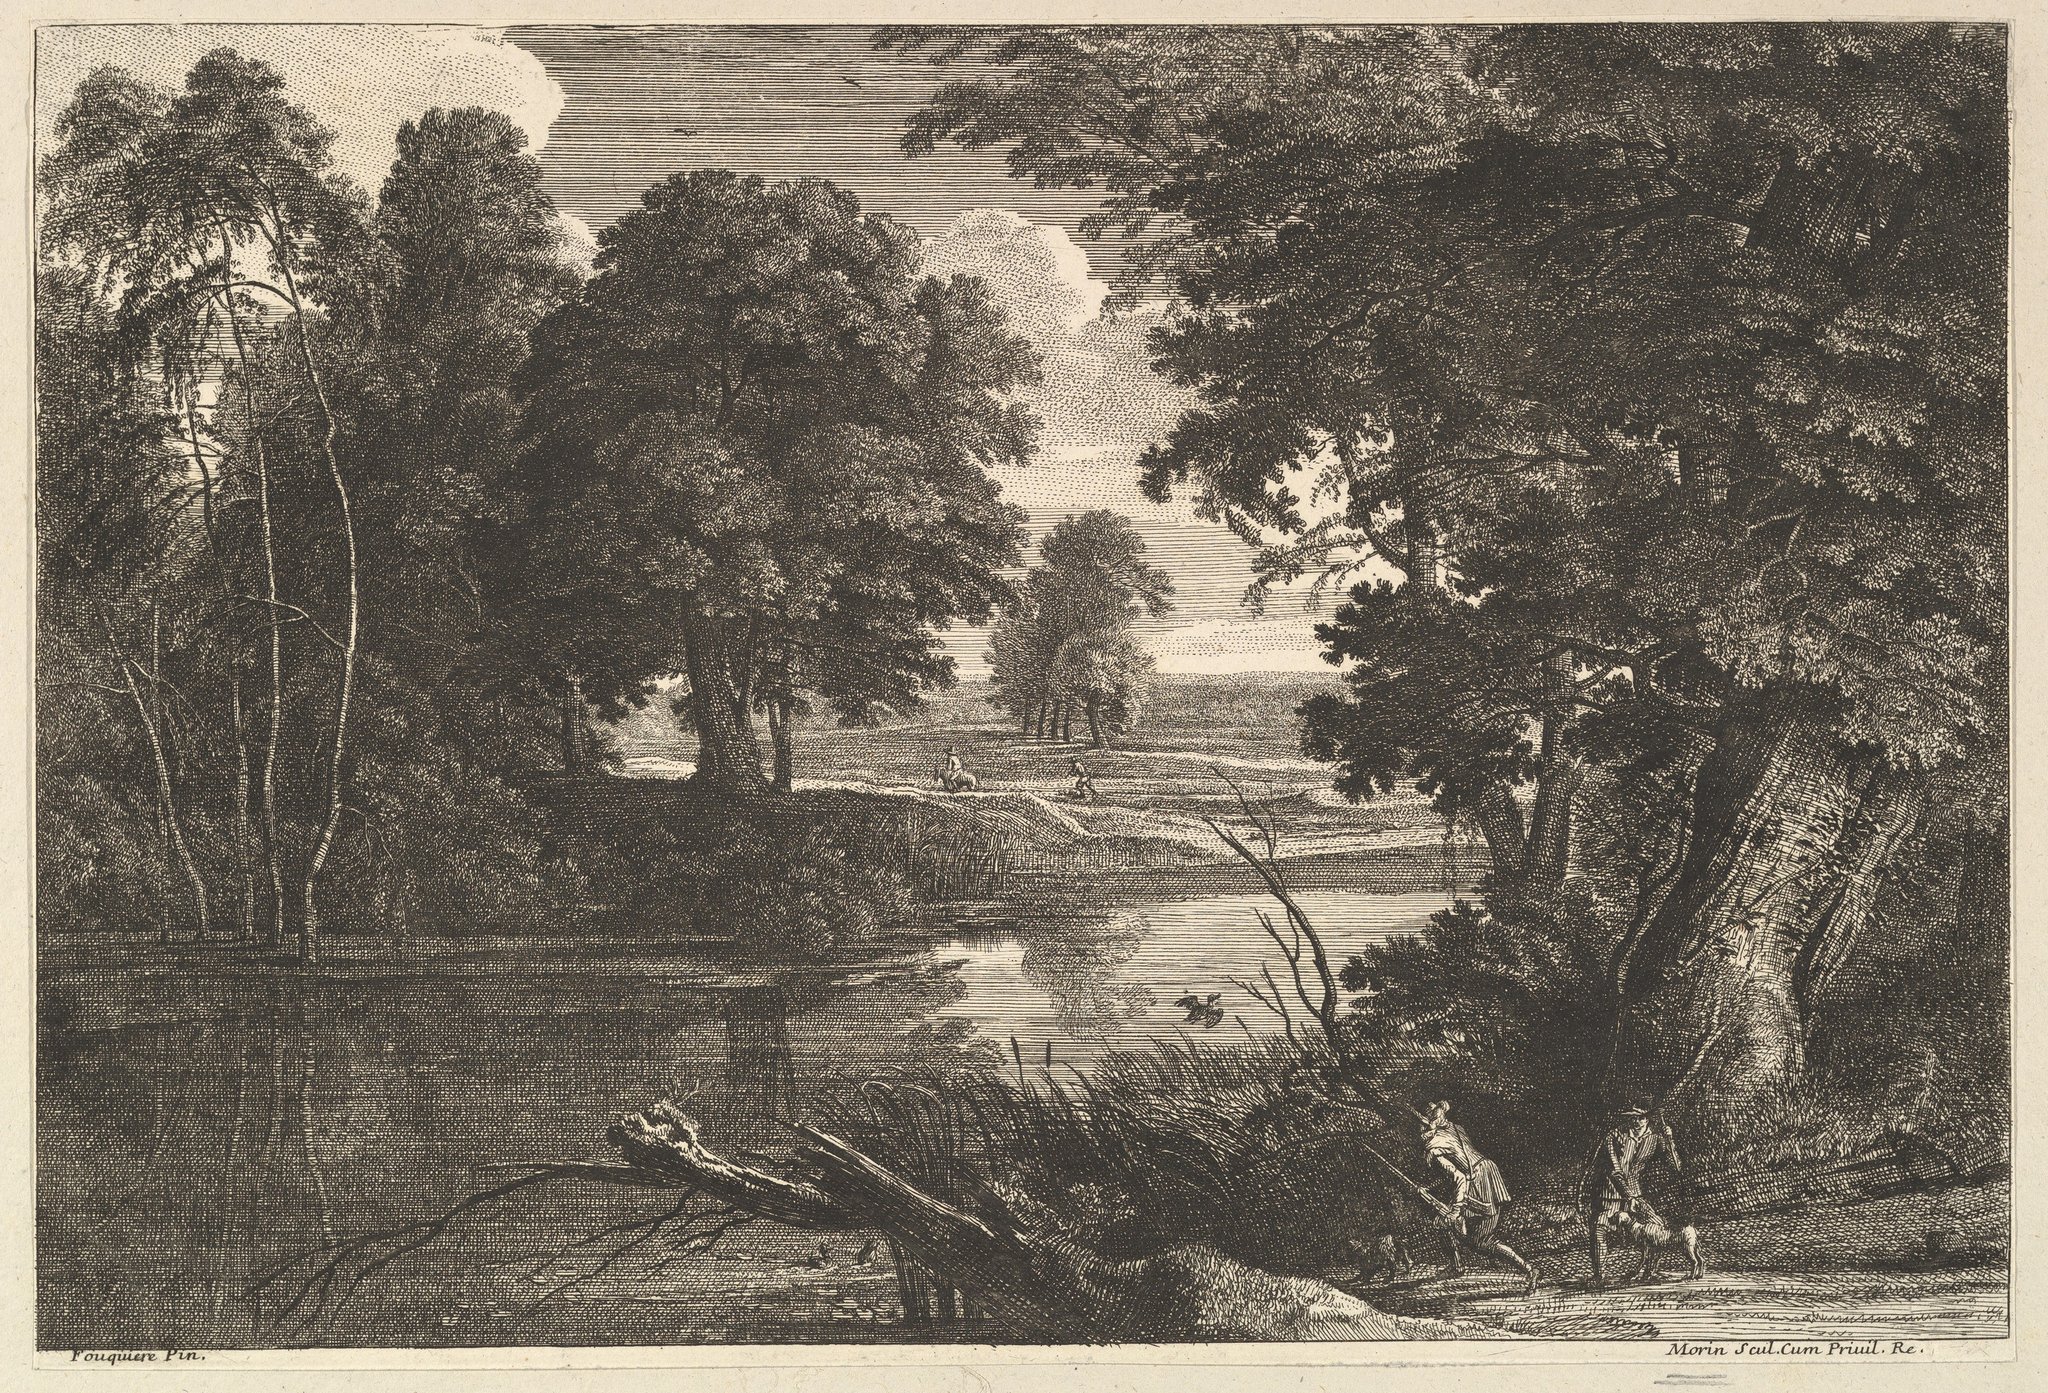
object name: print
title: La Chasse aux Canards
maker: jean morin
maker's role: artist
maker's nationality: french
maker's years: 1605-1650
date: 1605-1650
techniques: etching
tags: men,hunting,trees